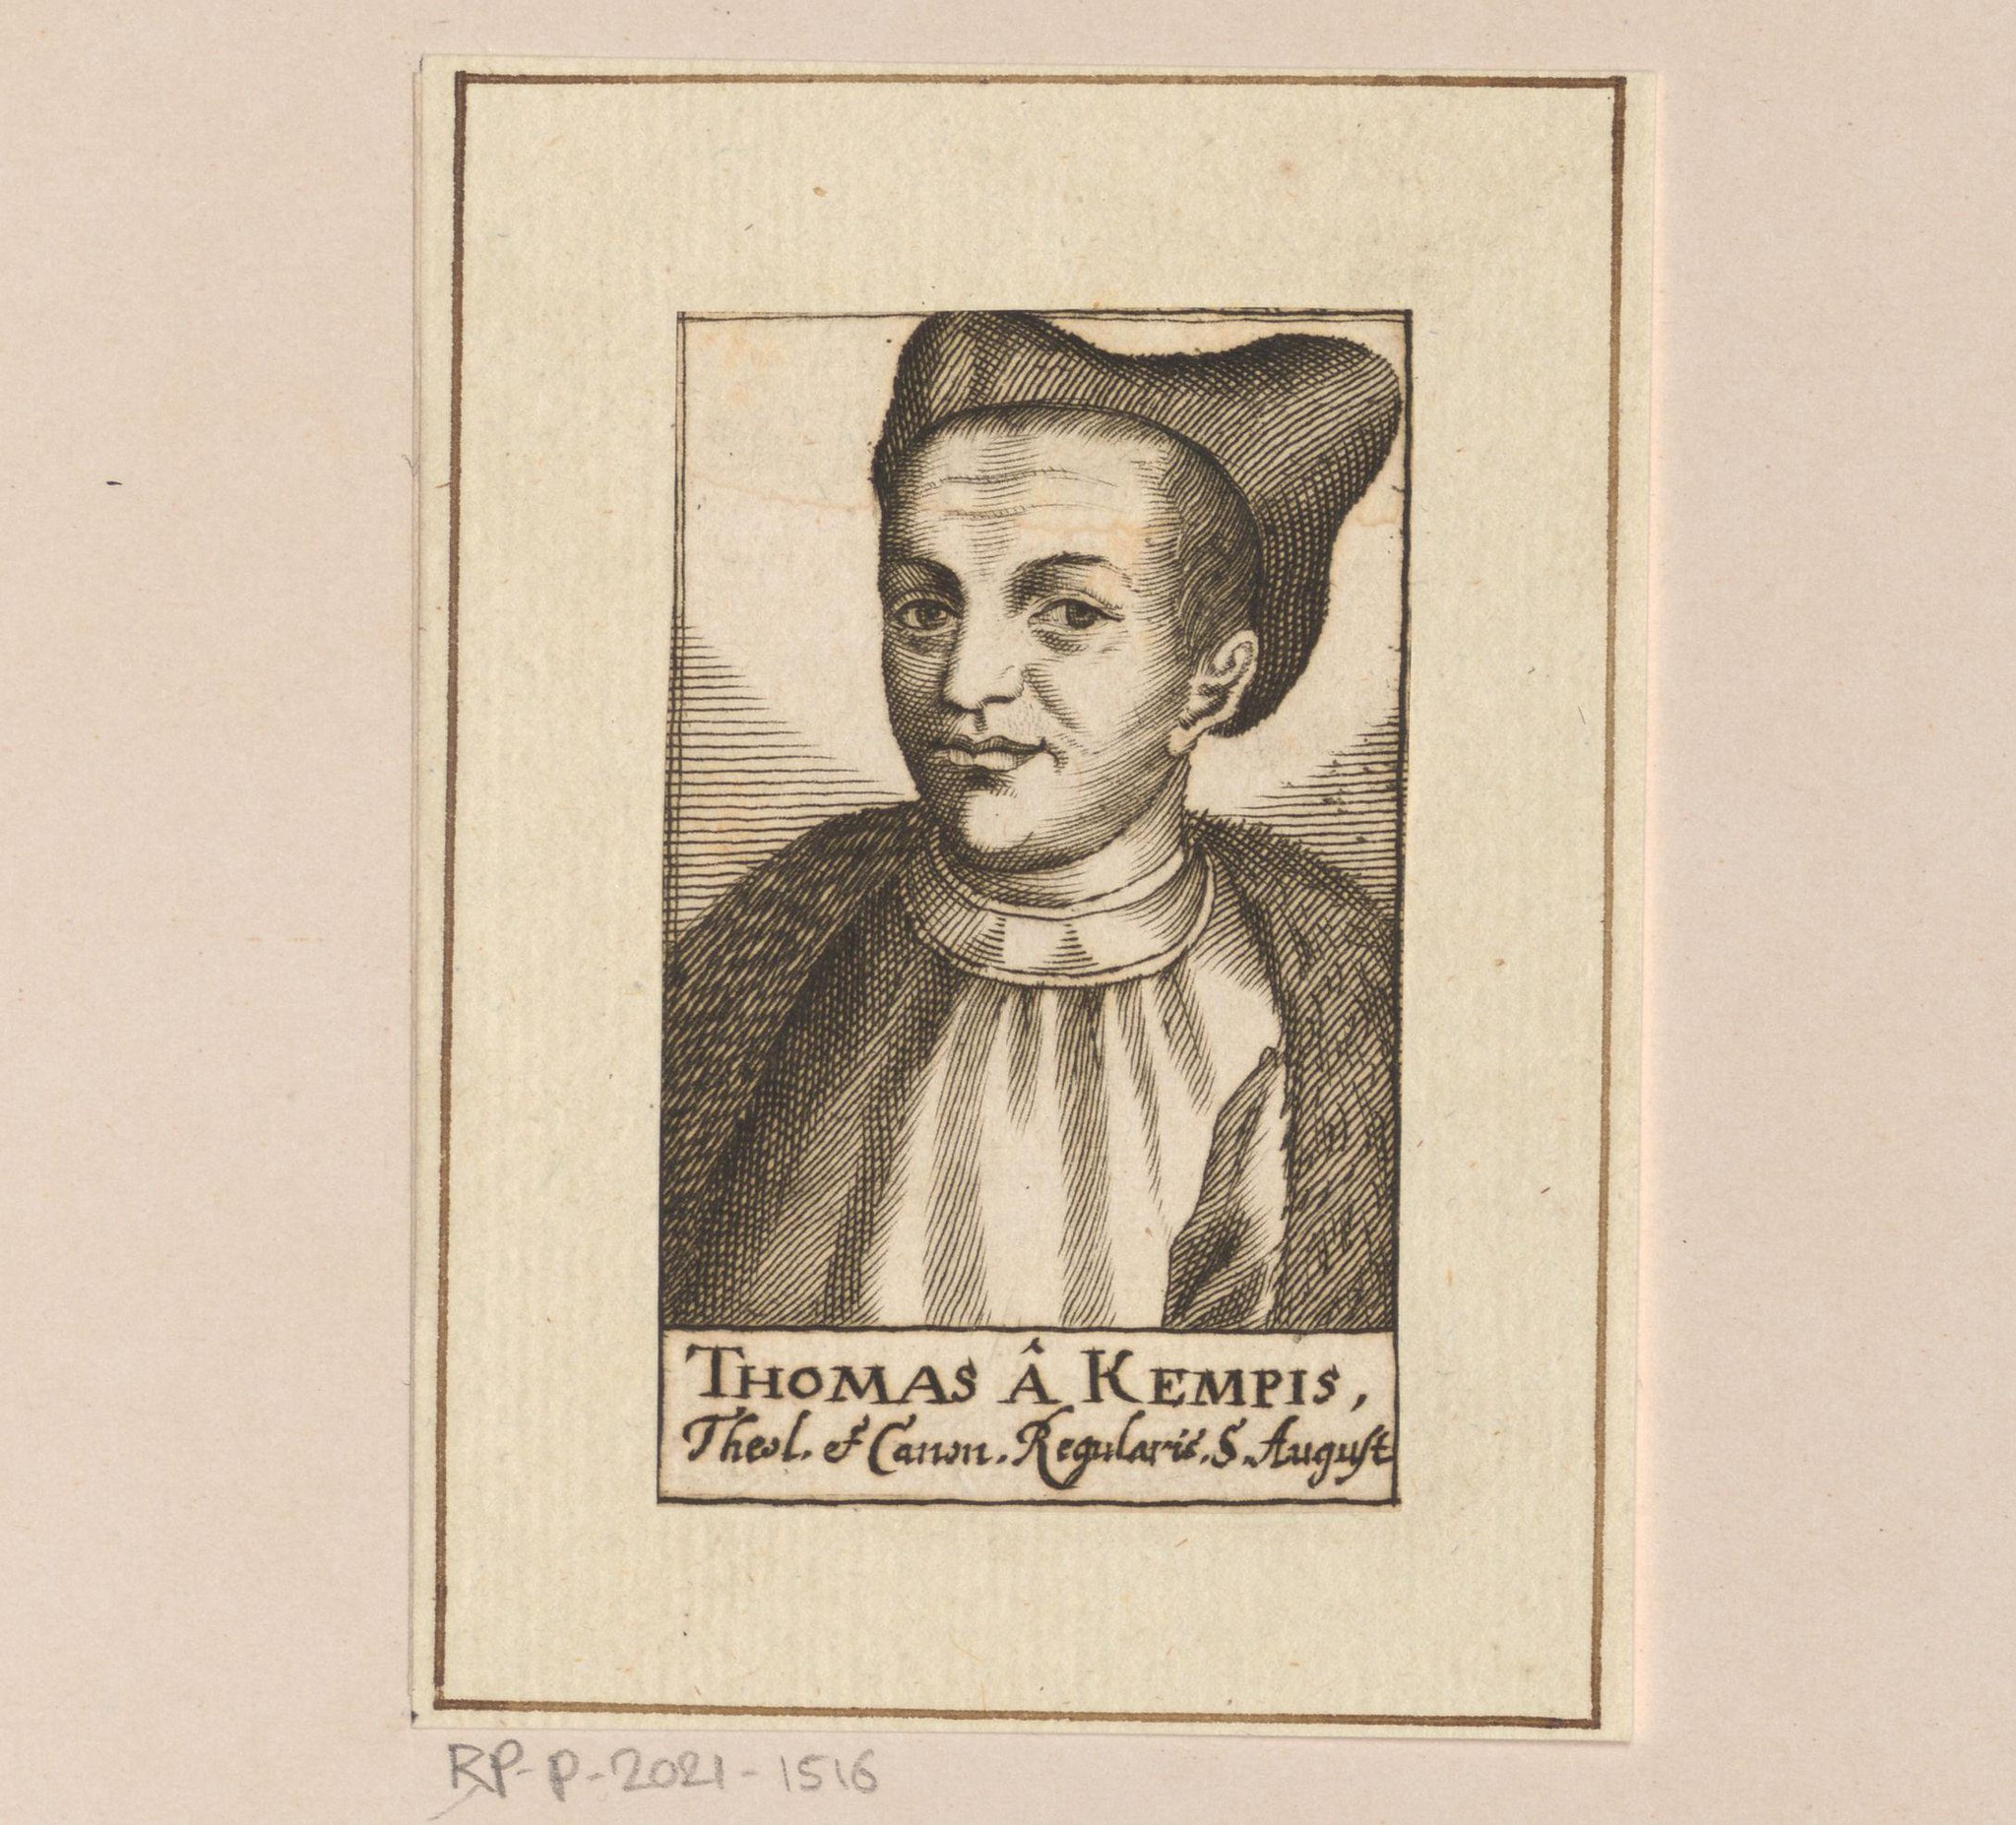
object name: print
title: Portret van Thomas à Kempis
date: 1688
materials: paper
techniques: engraving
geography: nuremberg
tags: priest, thomas à kempis, historical persons, monk(s), friar(s)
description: Prent waarschijnlijk uit: Freher, Paul. Theatrum virorum eruditione clarorum. Neurenberg: Johann Hoffmann, 1688.